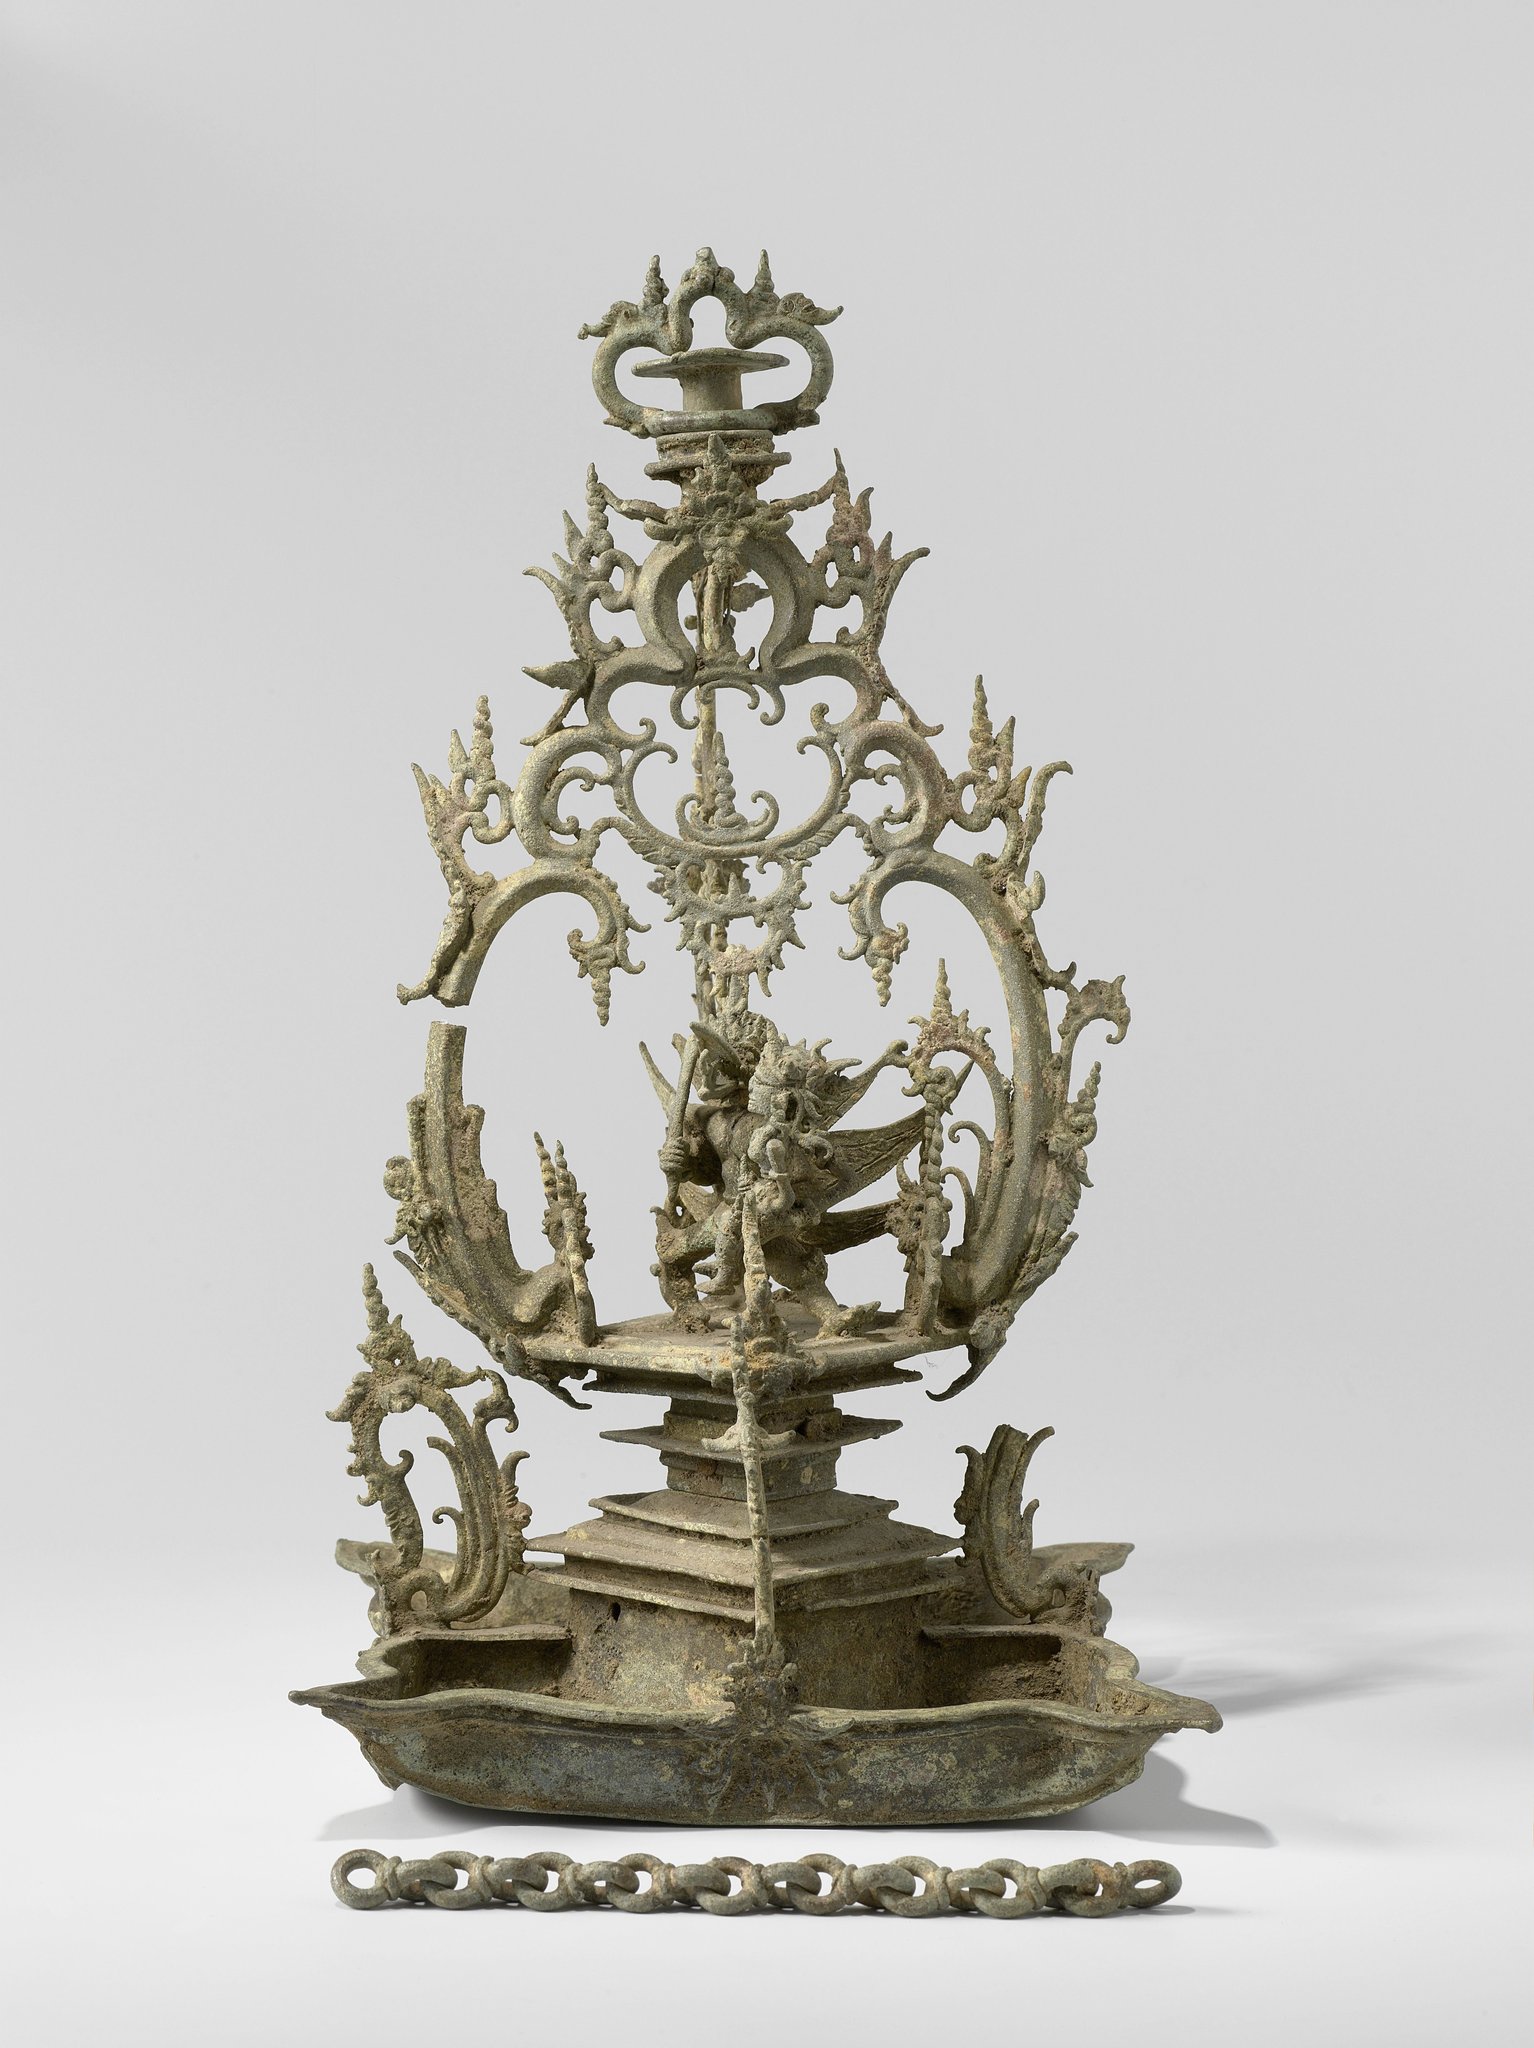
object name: lamp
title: Oil Lamp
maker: Anonymous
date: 1300-1500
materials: bronze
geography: east java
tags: garuda, half man half bird, ritual objects and ritual means ~ hinduism, buddhism, jainism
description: Fire, like water, plays an important role in rituals. Oil lamps are often suspended before the effigy of a god, both at home and in a temple. An essential part of a Hindu temple ceremony (puja) is worshipping the god by moving a lamp in front of his or her image. In ancient India, lamps were the most popular gifts to temples, along with cows to supply clarified butter (the fuel).